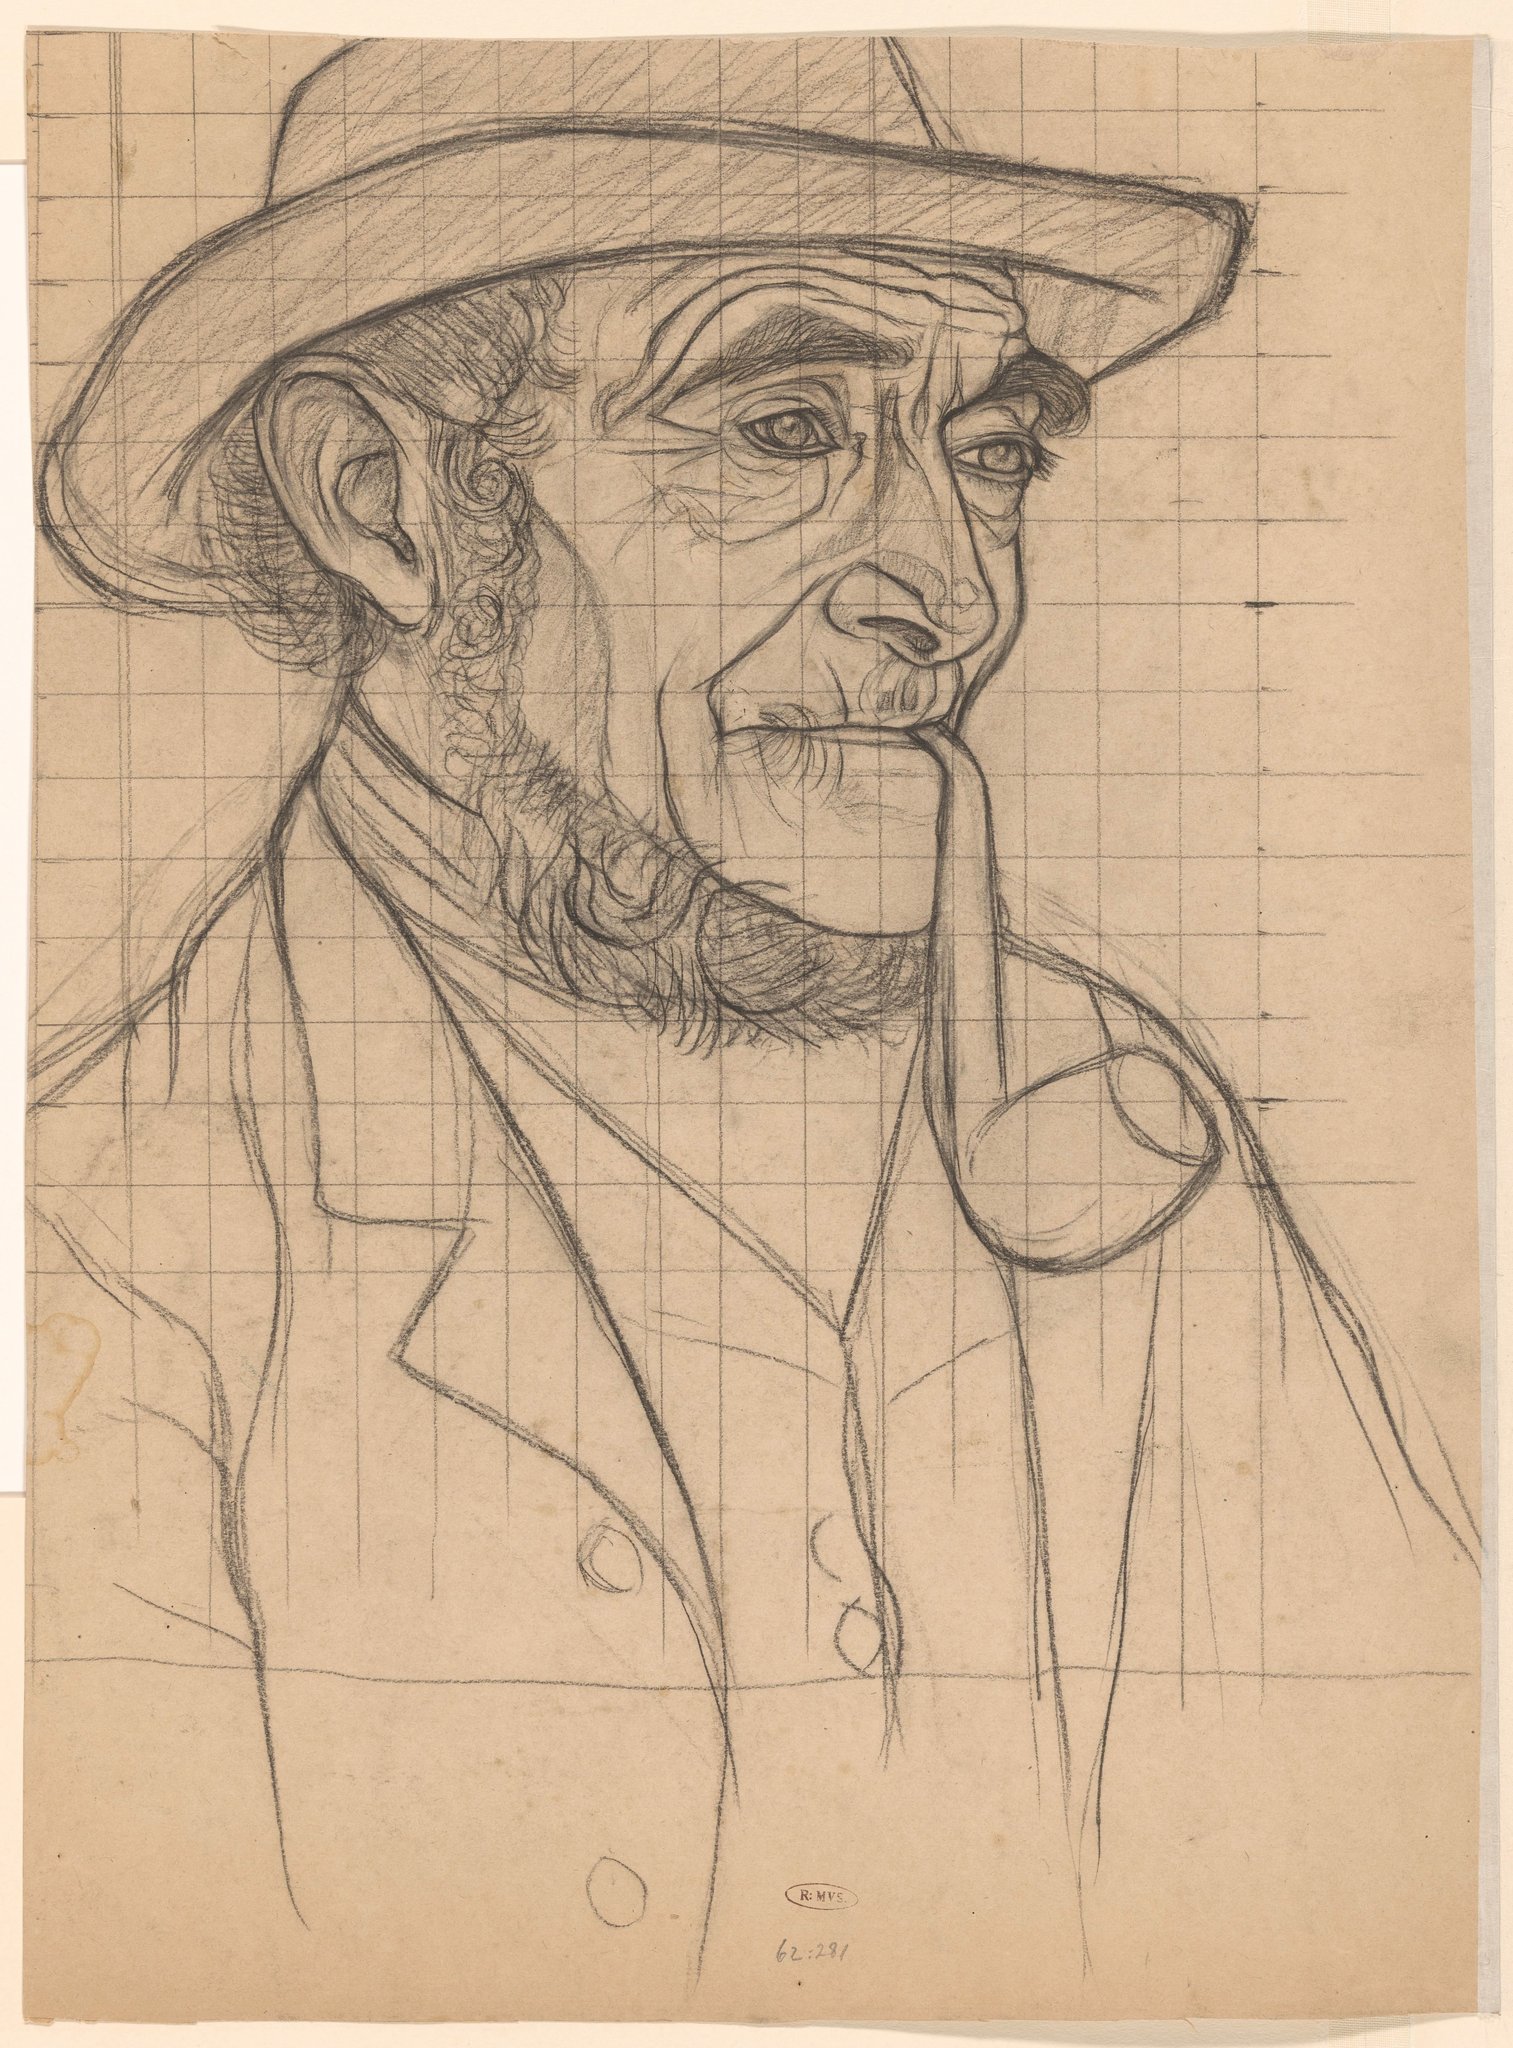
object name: drawing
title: Boer met een pijp, naar rechts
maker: jan veth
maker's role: designer, draughtsman, painter, print maker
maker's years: 1864-1925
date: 1874-1925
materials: chalk, paper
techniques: drawing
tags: anonymous historical person portrayed alone, farmers